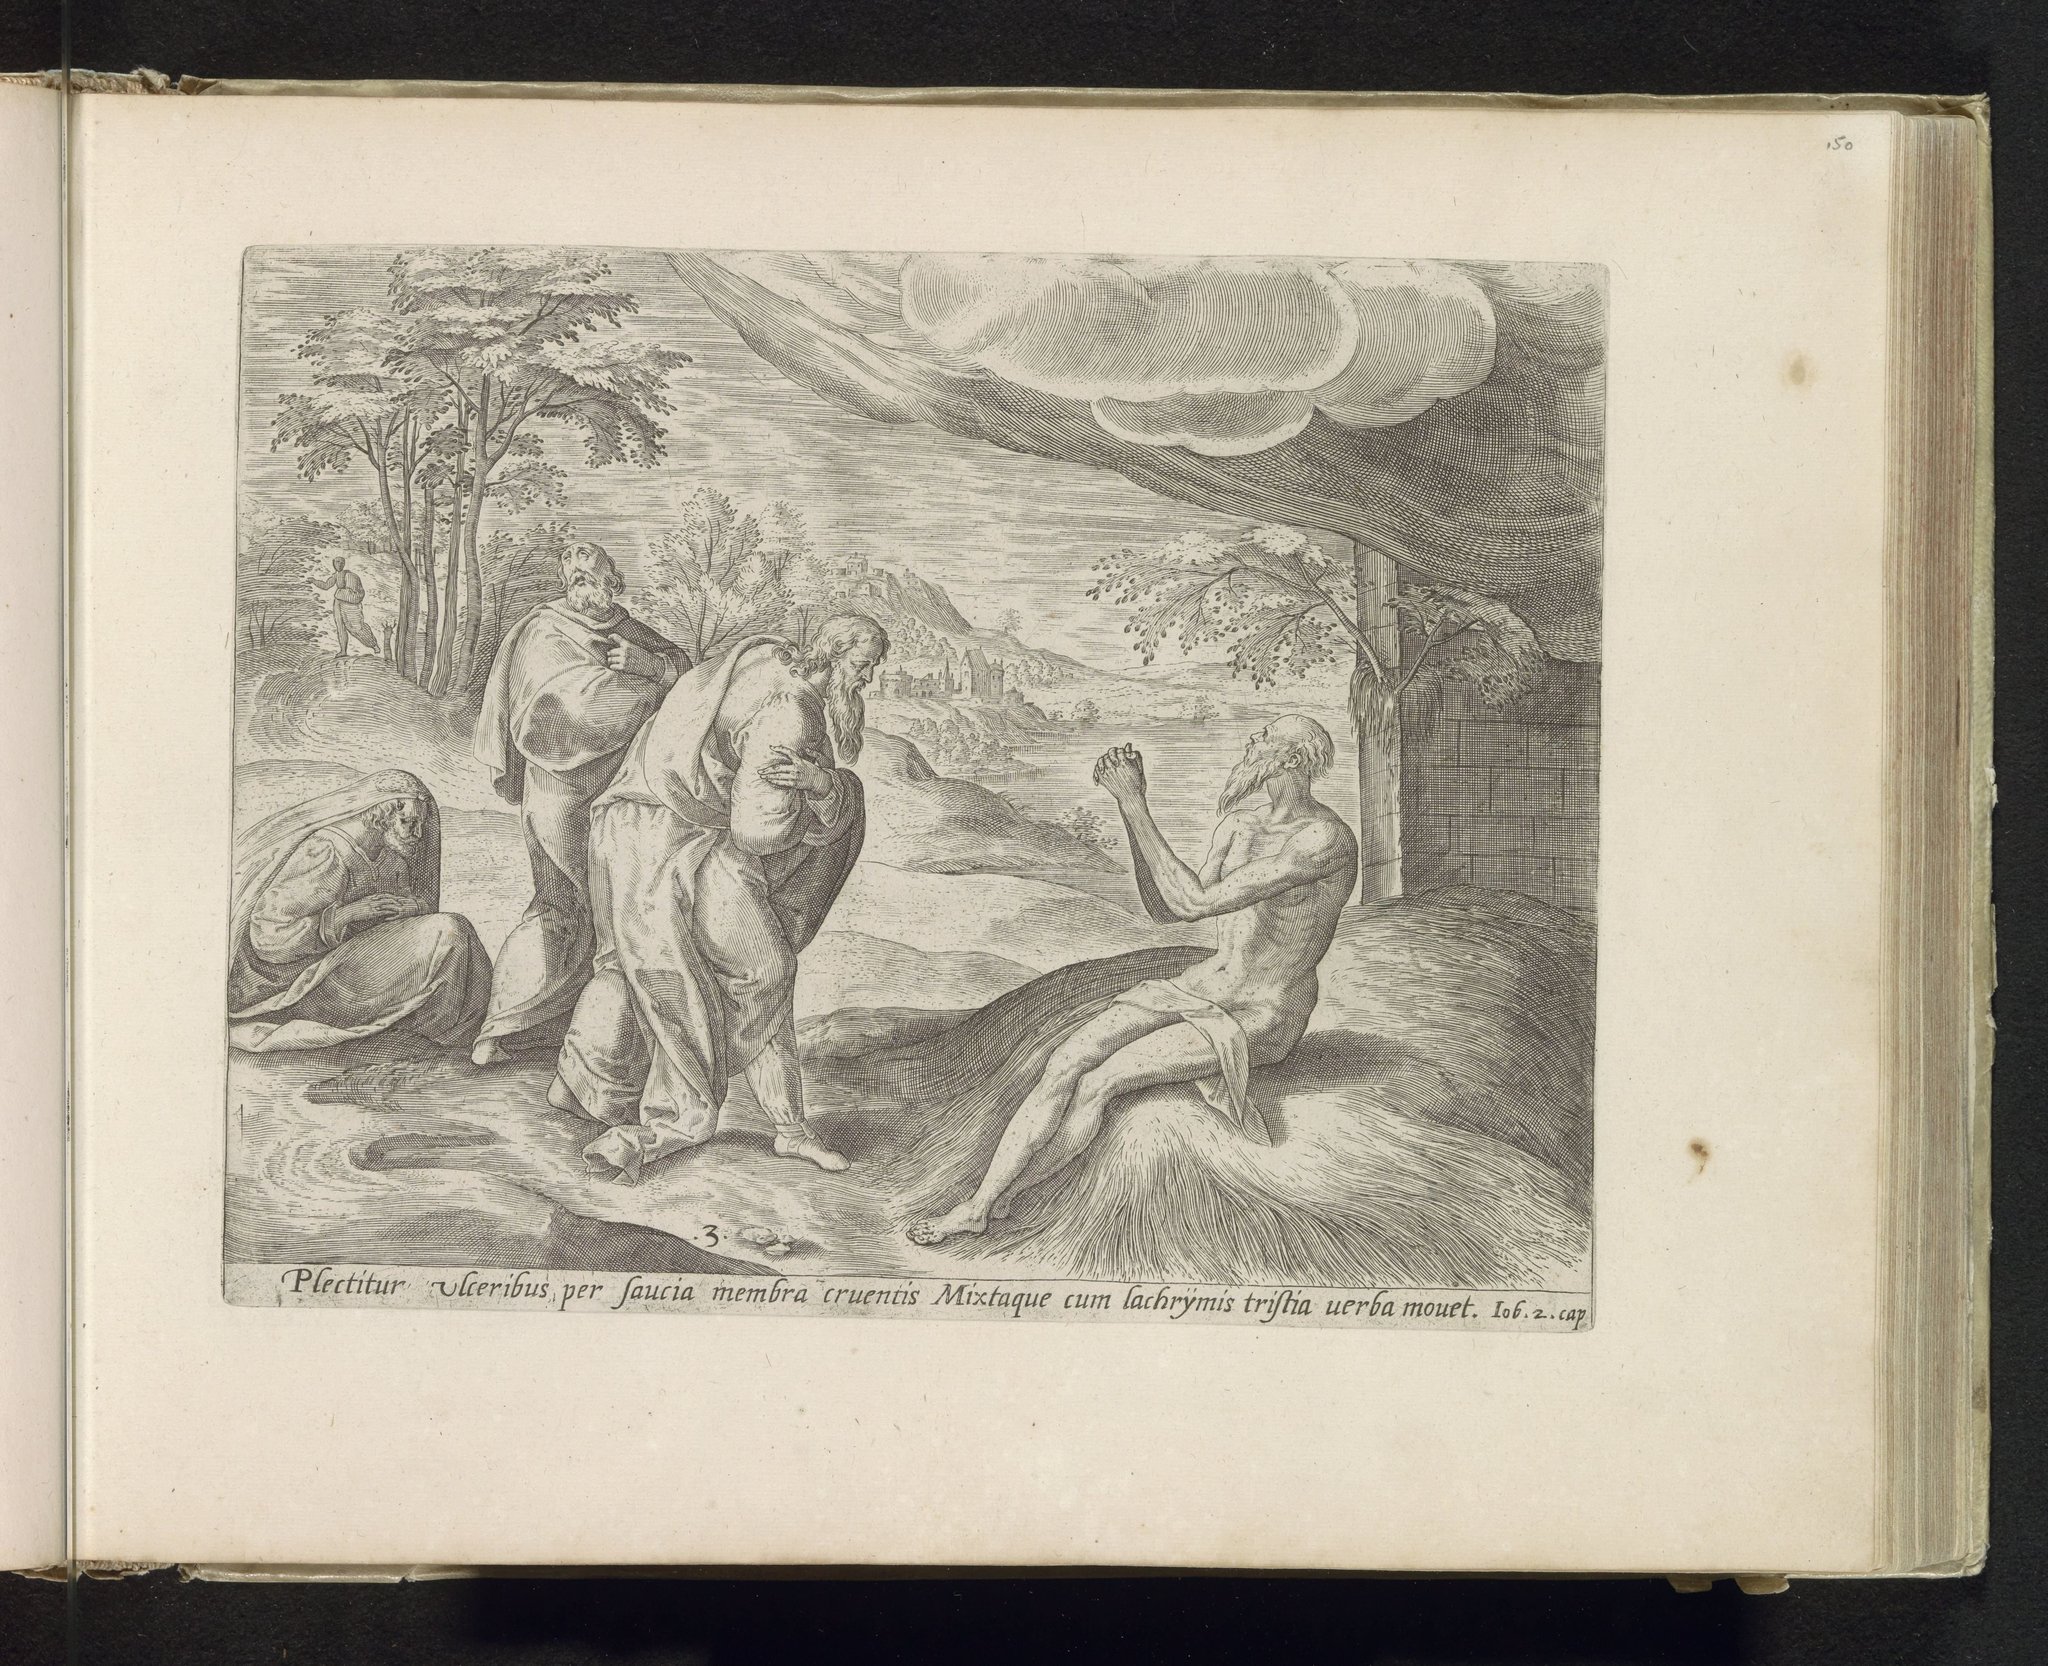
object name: album leaf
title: Geschiedenis van Job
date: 1585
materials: paper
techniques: engraving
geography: antwerp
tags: job on the dunghill visited by his friends (and wife)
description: Job zit op een mesthoop en wordt bezocht en bespot door zijn vrienden. Een van zijn vrienden zit in zak en as: hij heeft as op zijn hoofd gestrooid. Onder de voorstelling een verwijzing in het Latijn naar de Bijbeltekst in Job 2. Deze prent maakt deel uit van een album.